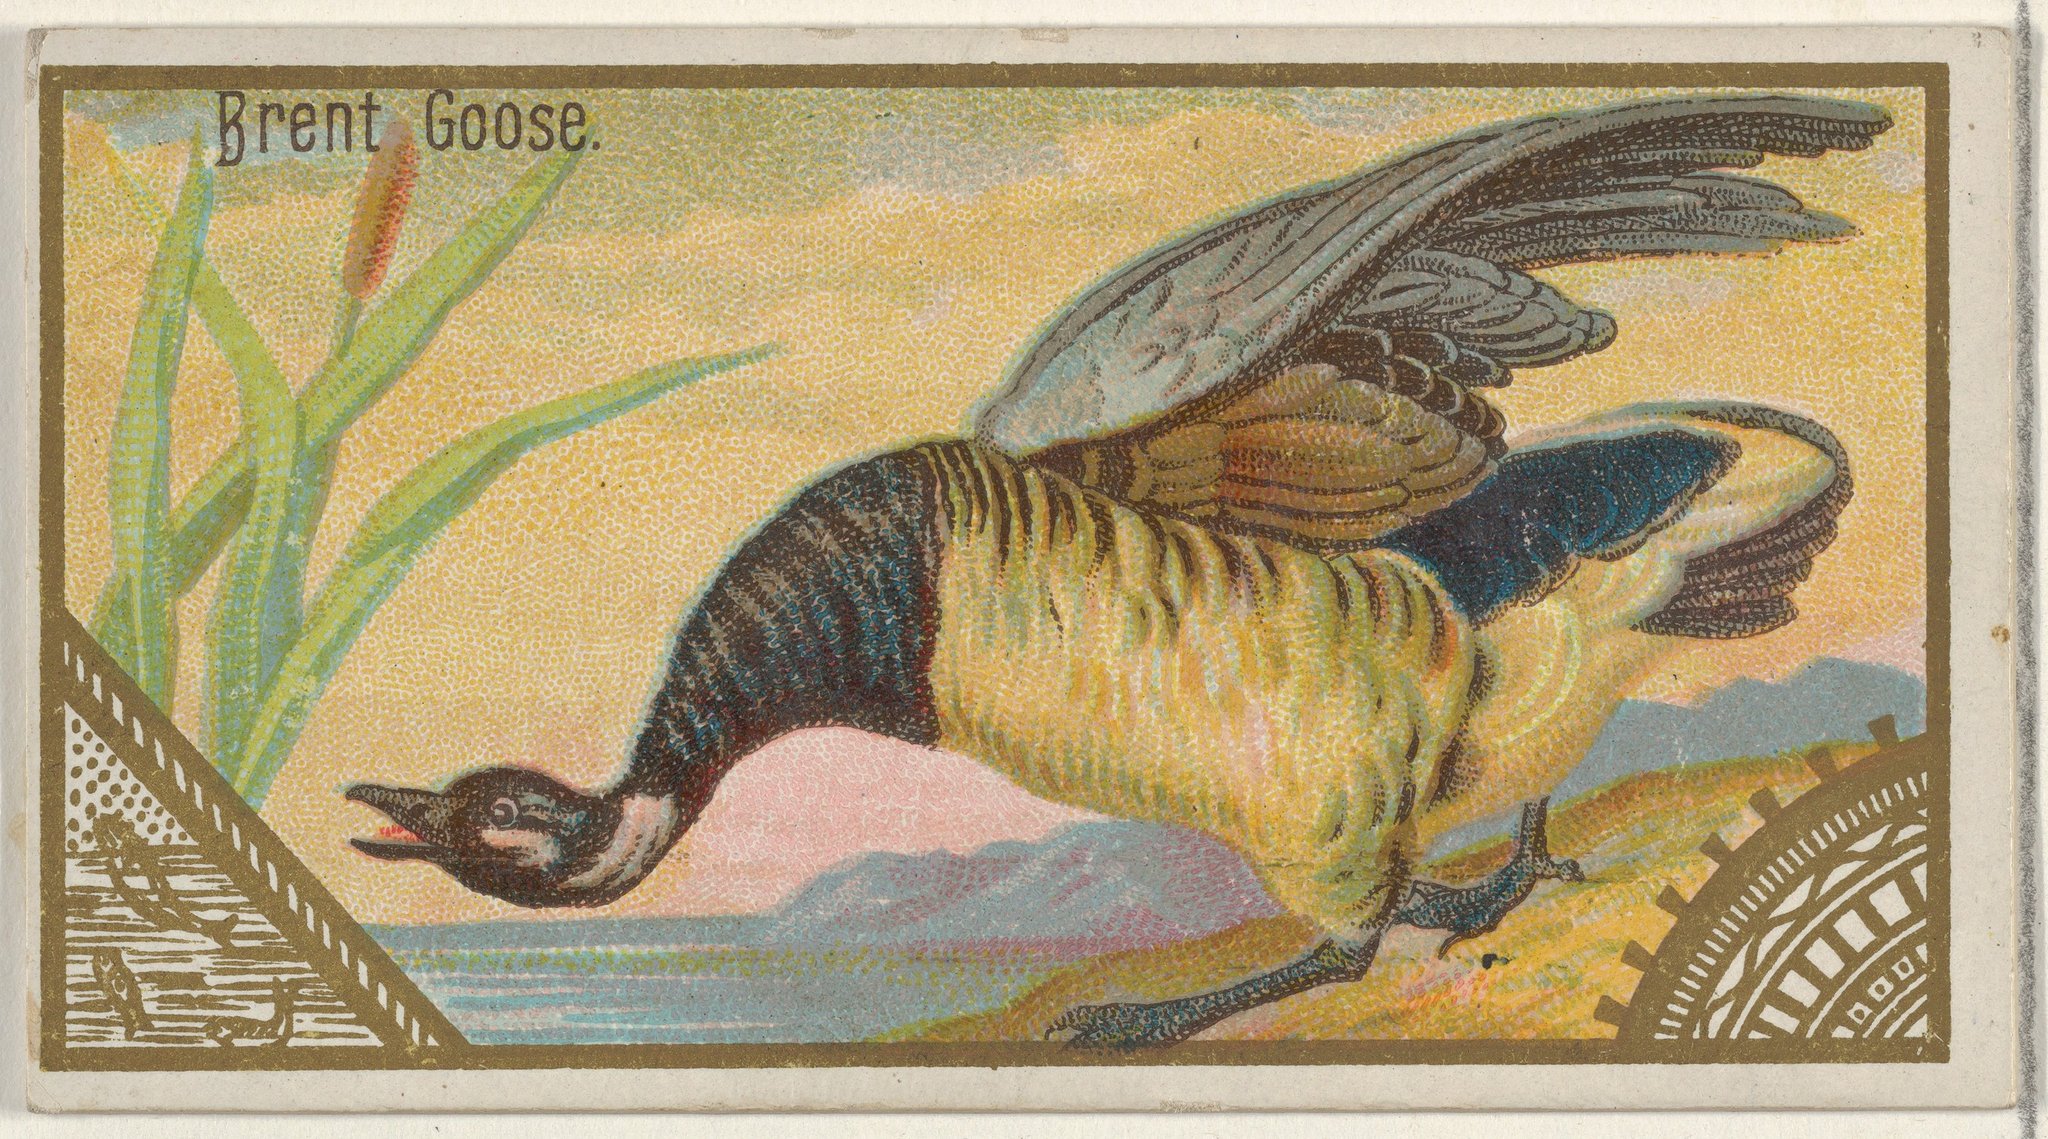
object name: print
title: Brent Goose, from the Game Birds series (N13) for Allen & Ginter Cigarettes Brands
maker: allen & ginter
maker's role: publisher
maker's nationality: american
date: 1889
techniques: color lithograph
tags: geese